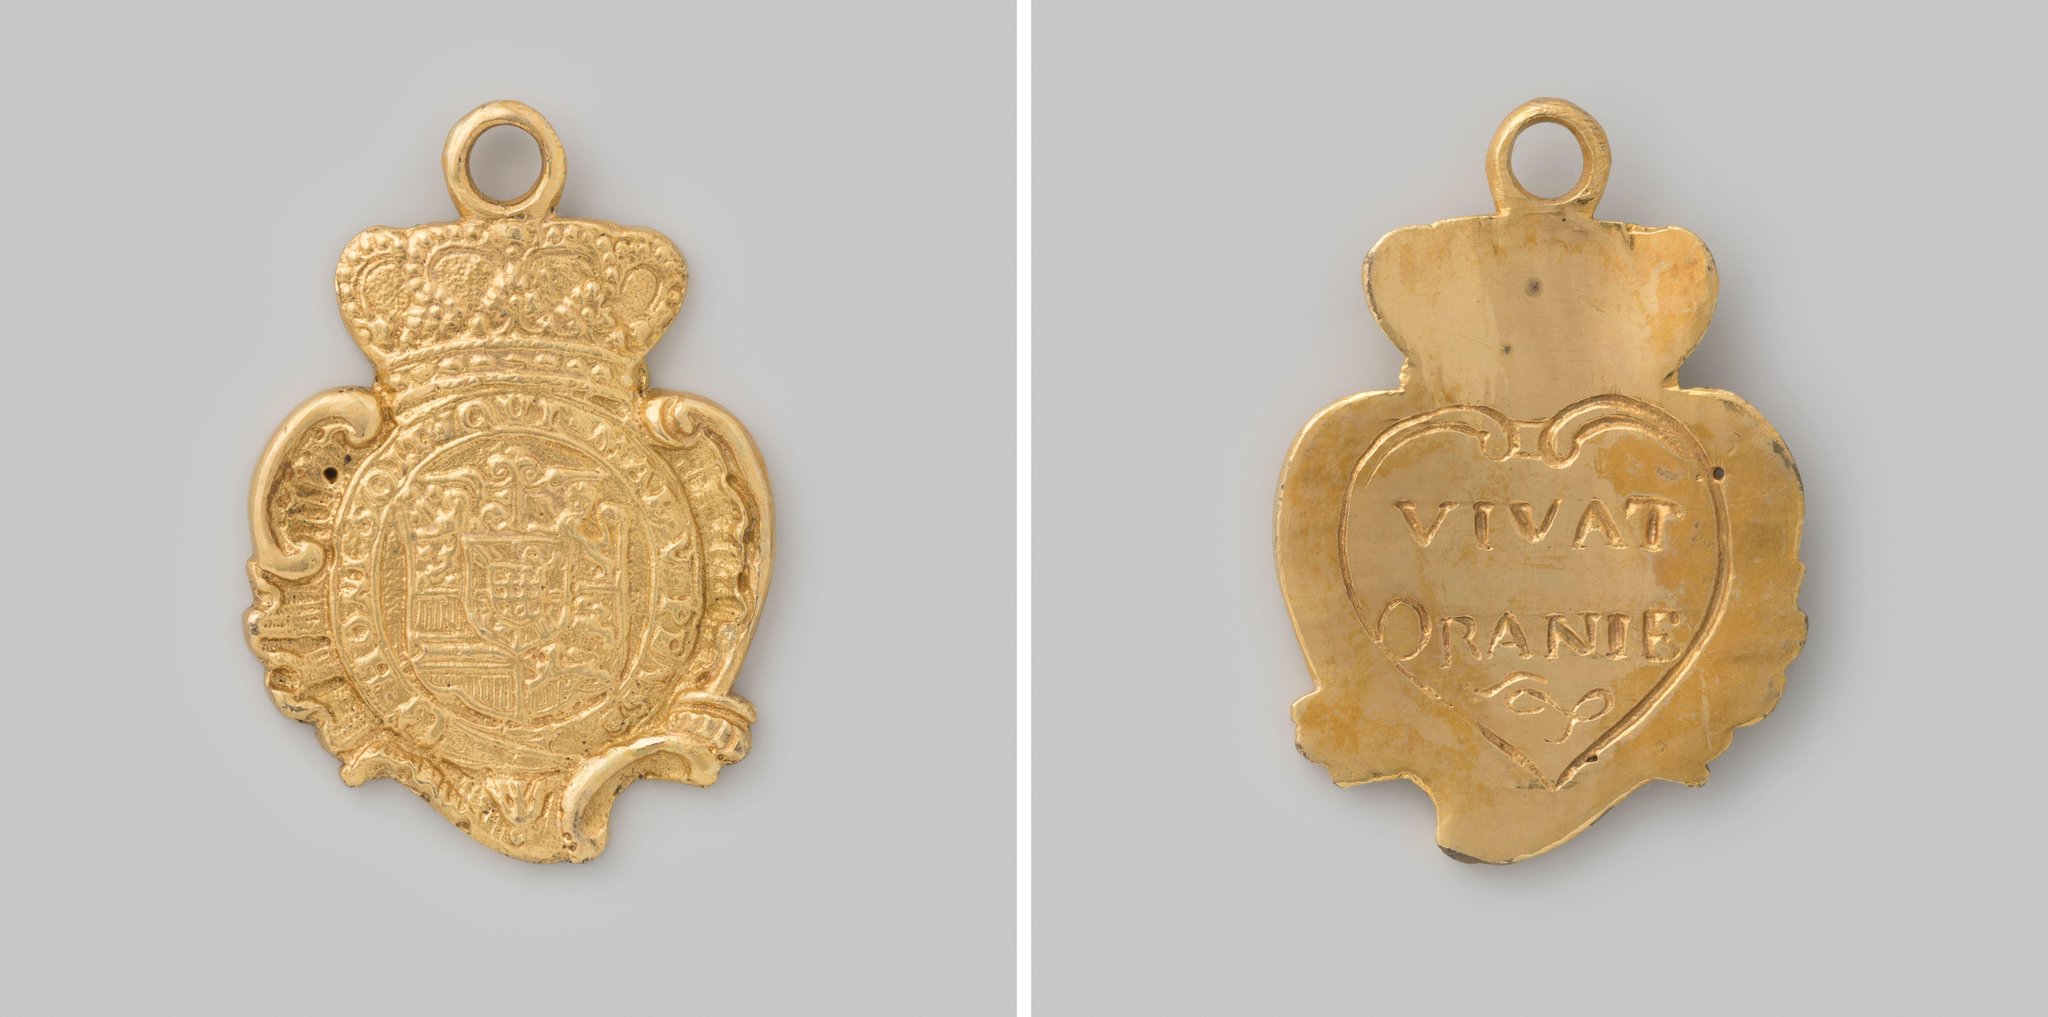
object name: insignia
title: Verheffing van Willem IV, prins van Oranje-Nassau tot stadhouder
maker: Anonymous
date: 1747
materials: metal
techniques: casting, engraving, gilding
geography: netherlands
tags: the hague, willem iv (prins van oranje-nassau)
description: draagteken binnen sierrand onder kroon aan draagoog. Voorzijde: wapenschild binnen gegespte riem met opschrift. Keerzijde: opschrift